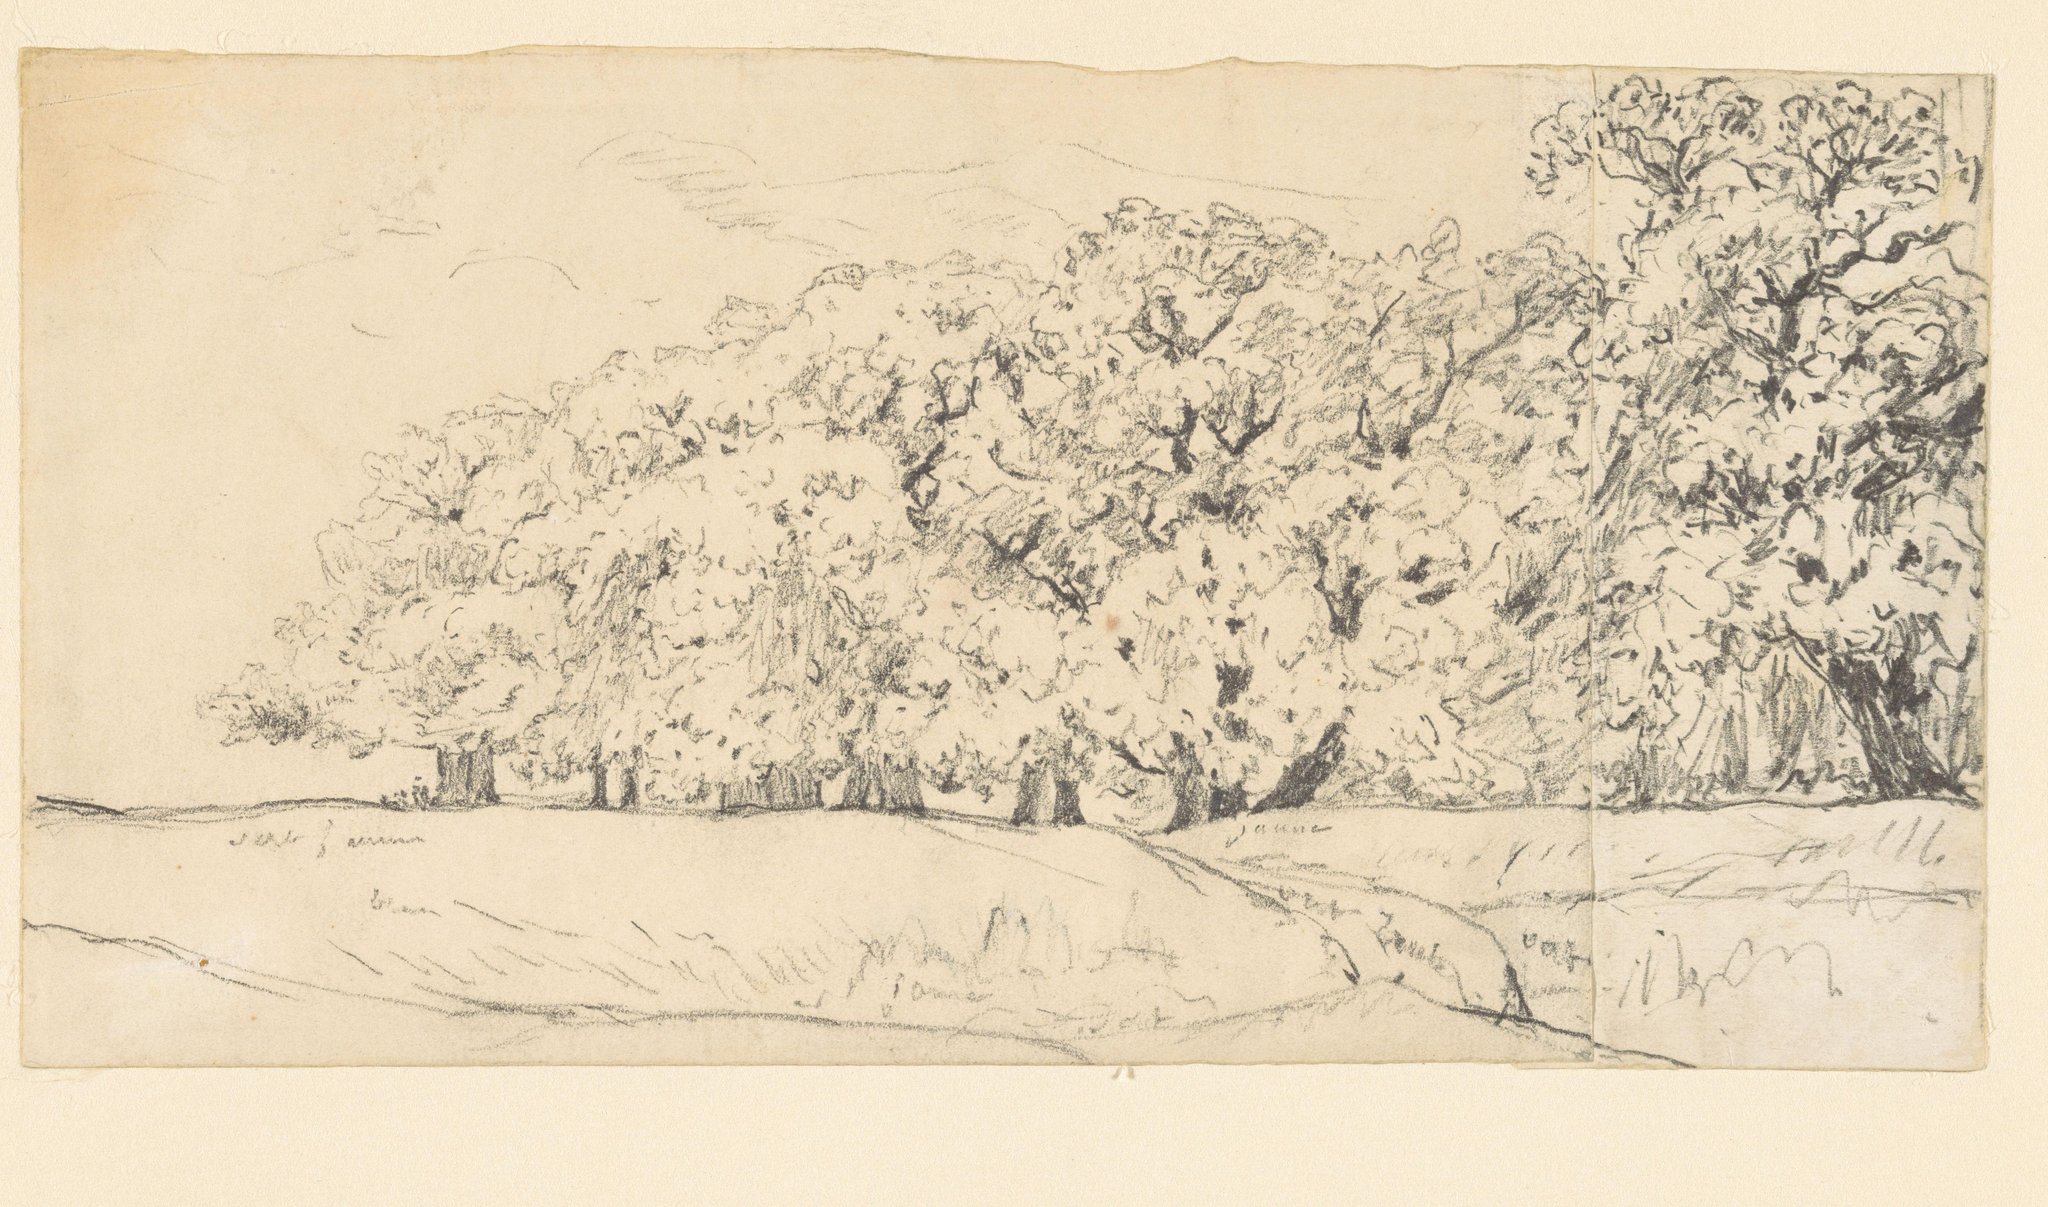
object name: drawing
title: Schetsje van een bosrand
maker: théodore rousseau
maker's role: draughtsman, painter, print maker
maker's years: 1812-1867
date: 1822-1867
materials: chalk, paper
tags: fringe, edge of the wood